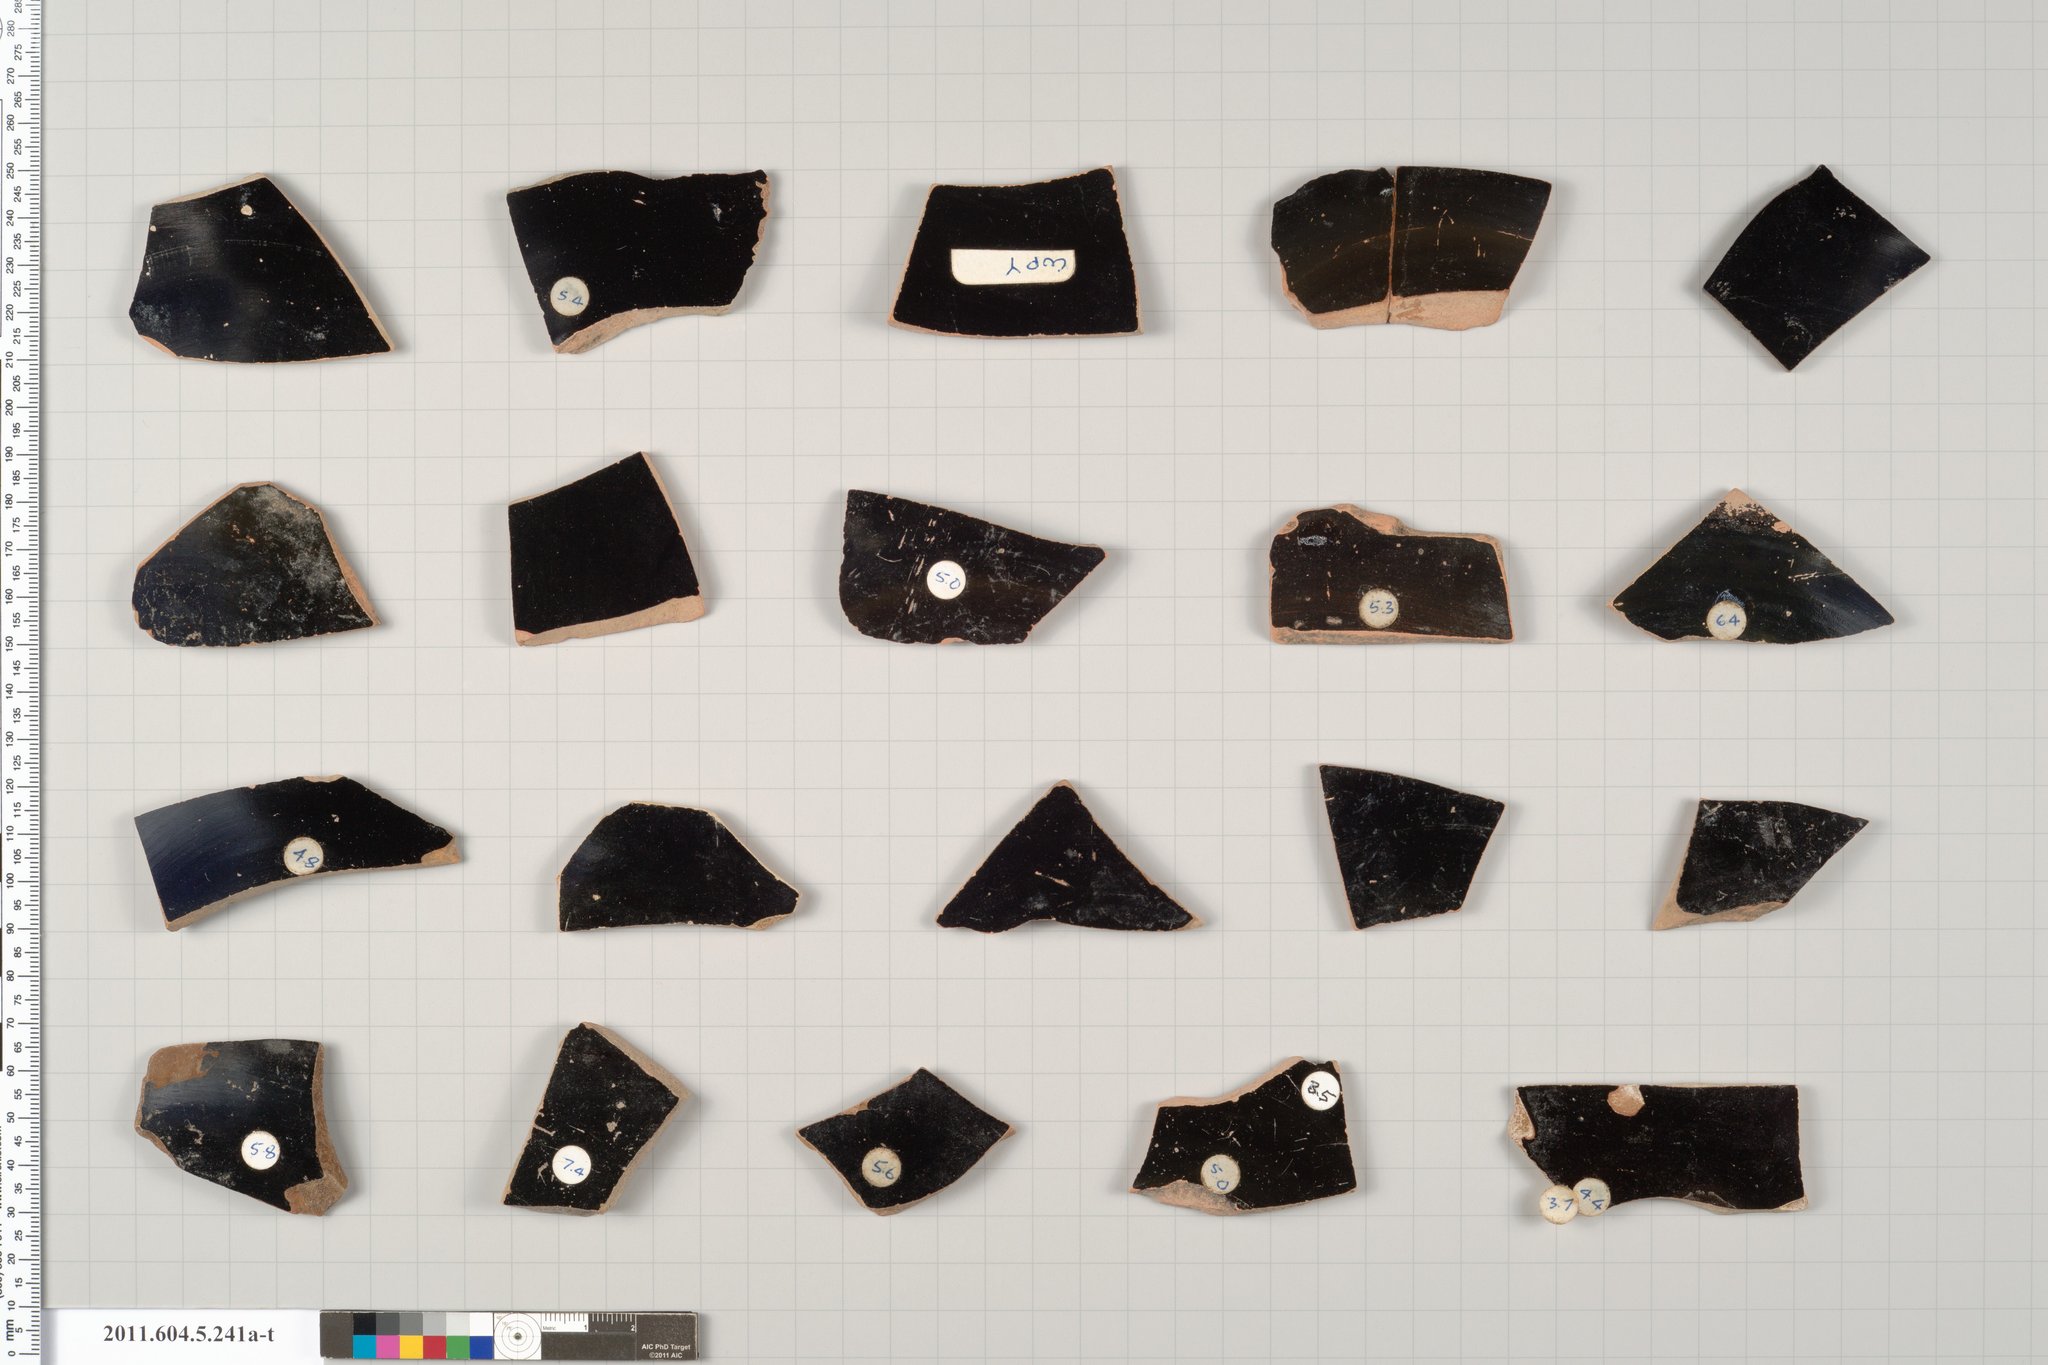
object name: kylix fragment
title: Terracotta fragments of kylikes (drinking cups)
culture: greek, attic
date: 600-401 BCE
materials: terracotta